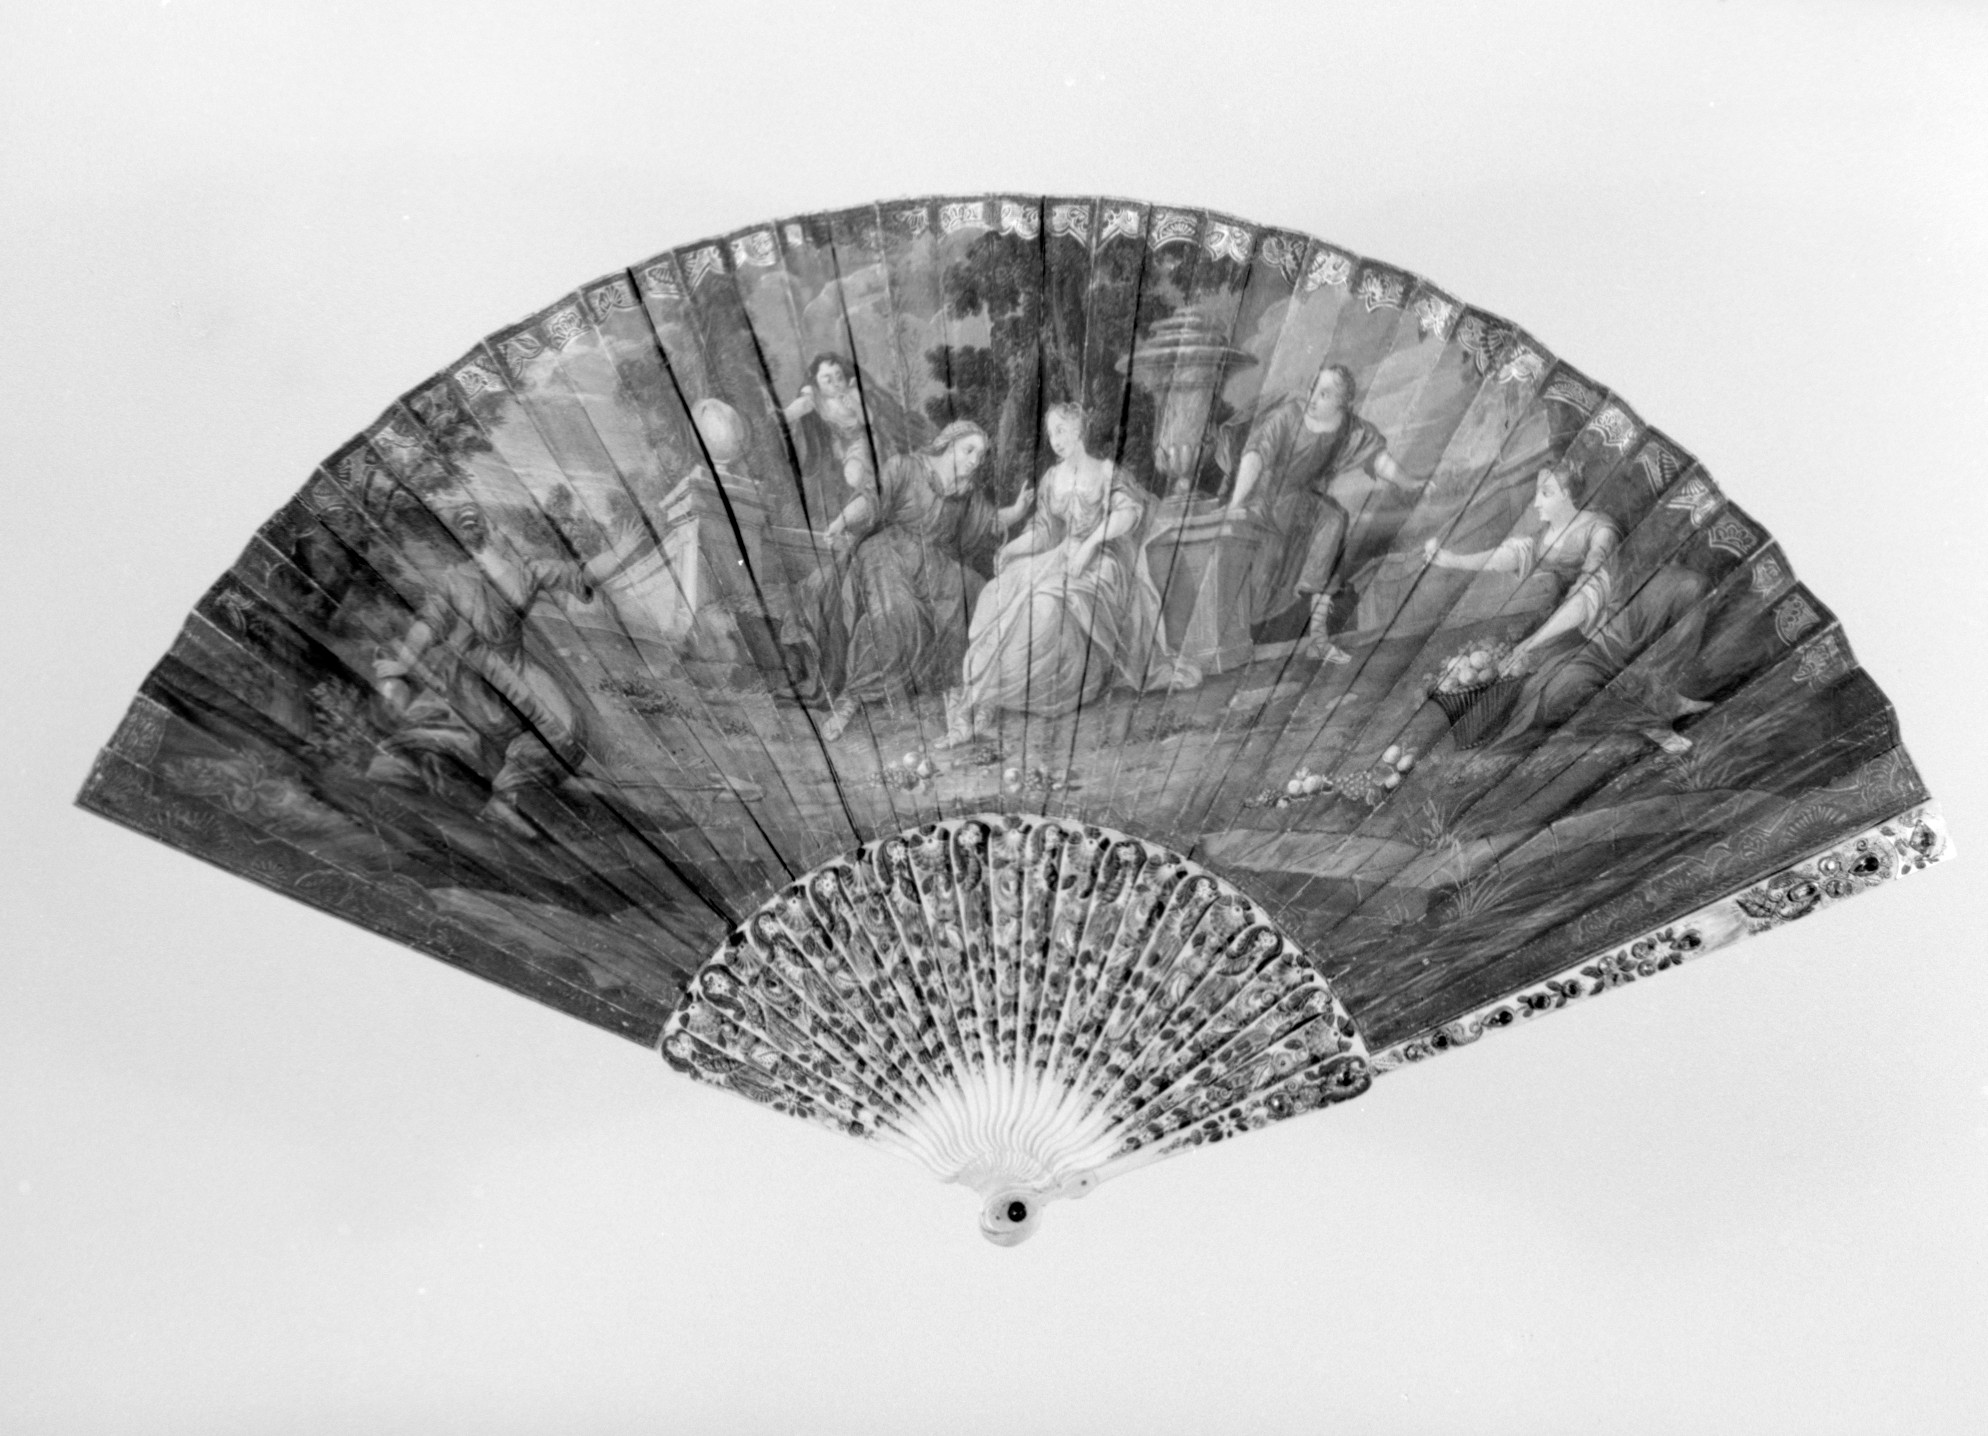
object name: fan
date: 1701-1800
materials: ivory, parchment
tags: women